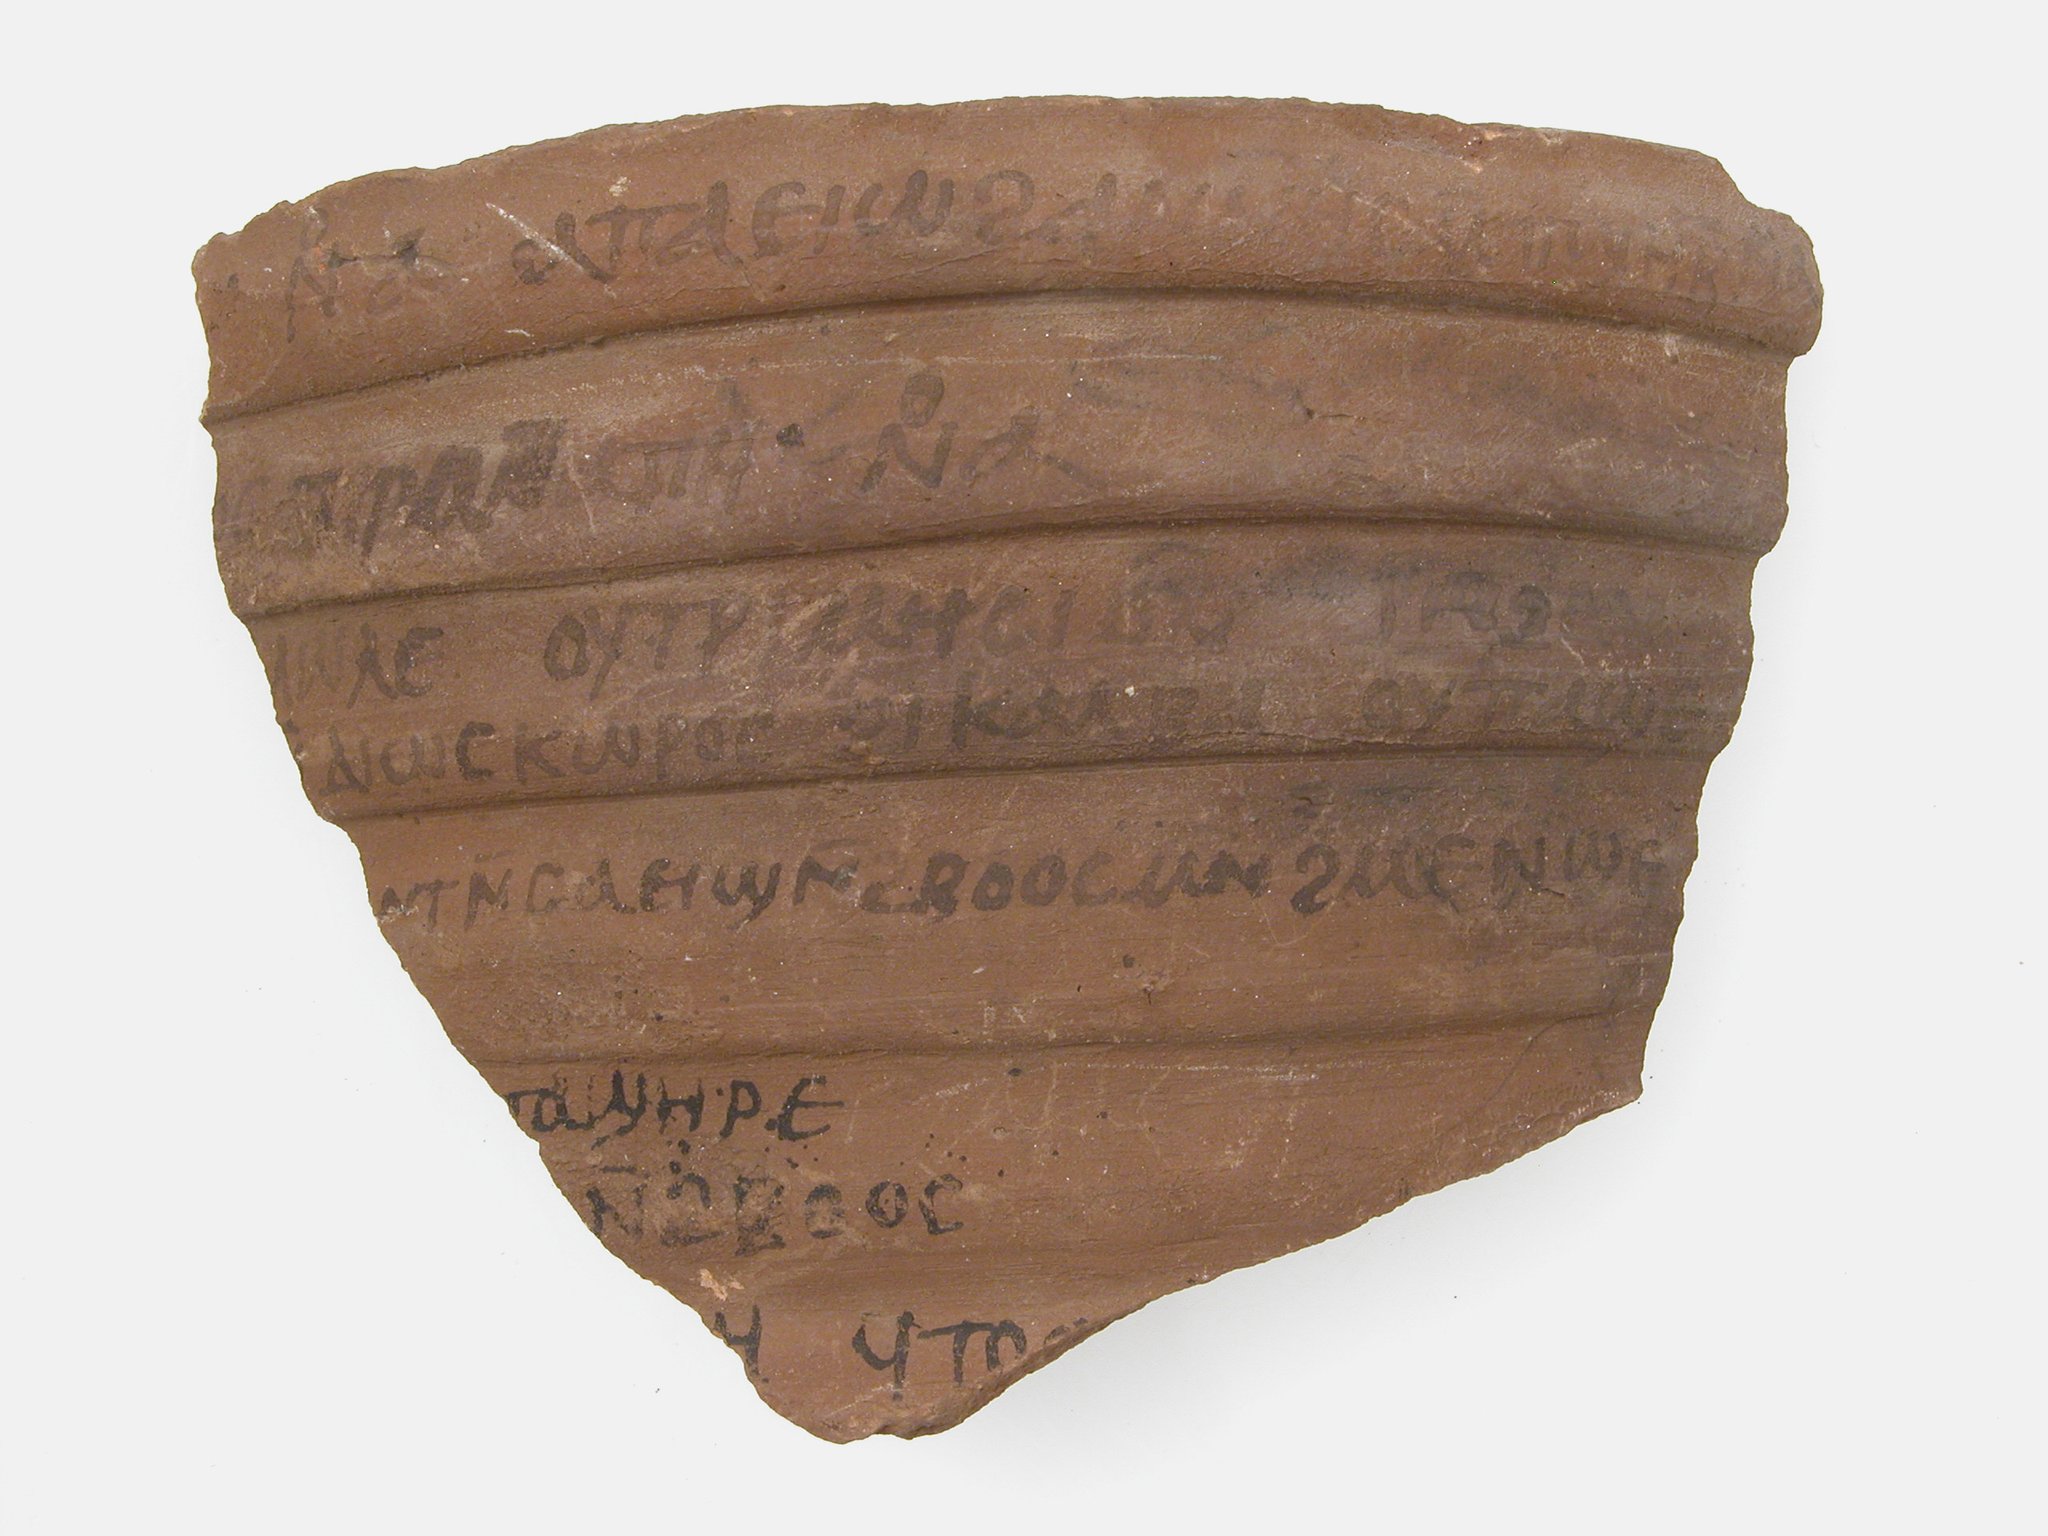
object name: ostrakon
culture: coptic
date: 601-700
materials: ink, pottery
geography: egypt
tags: documents